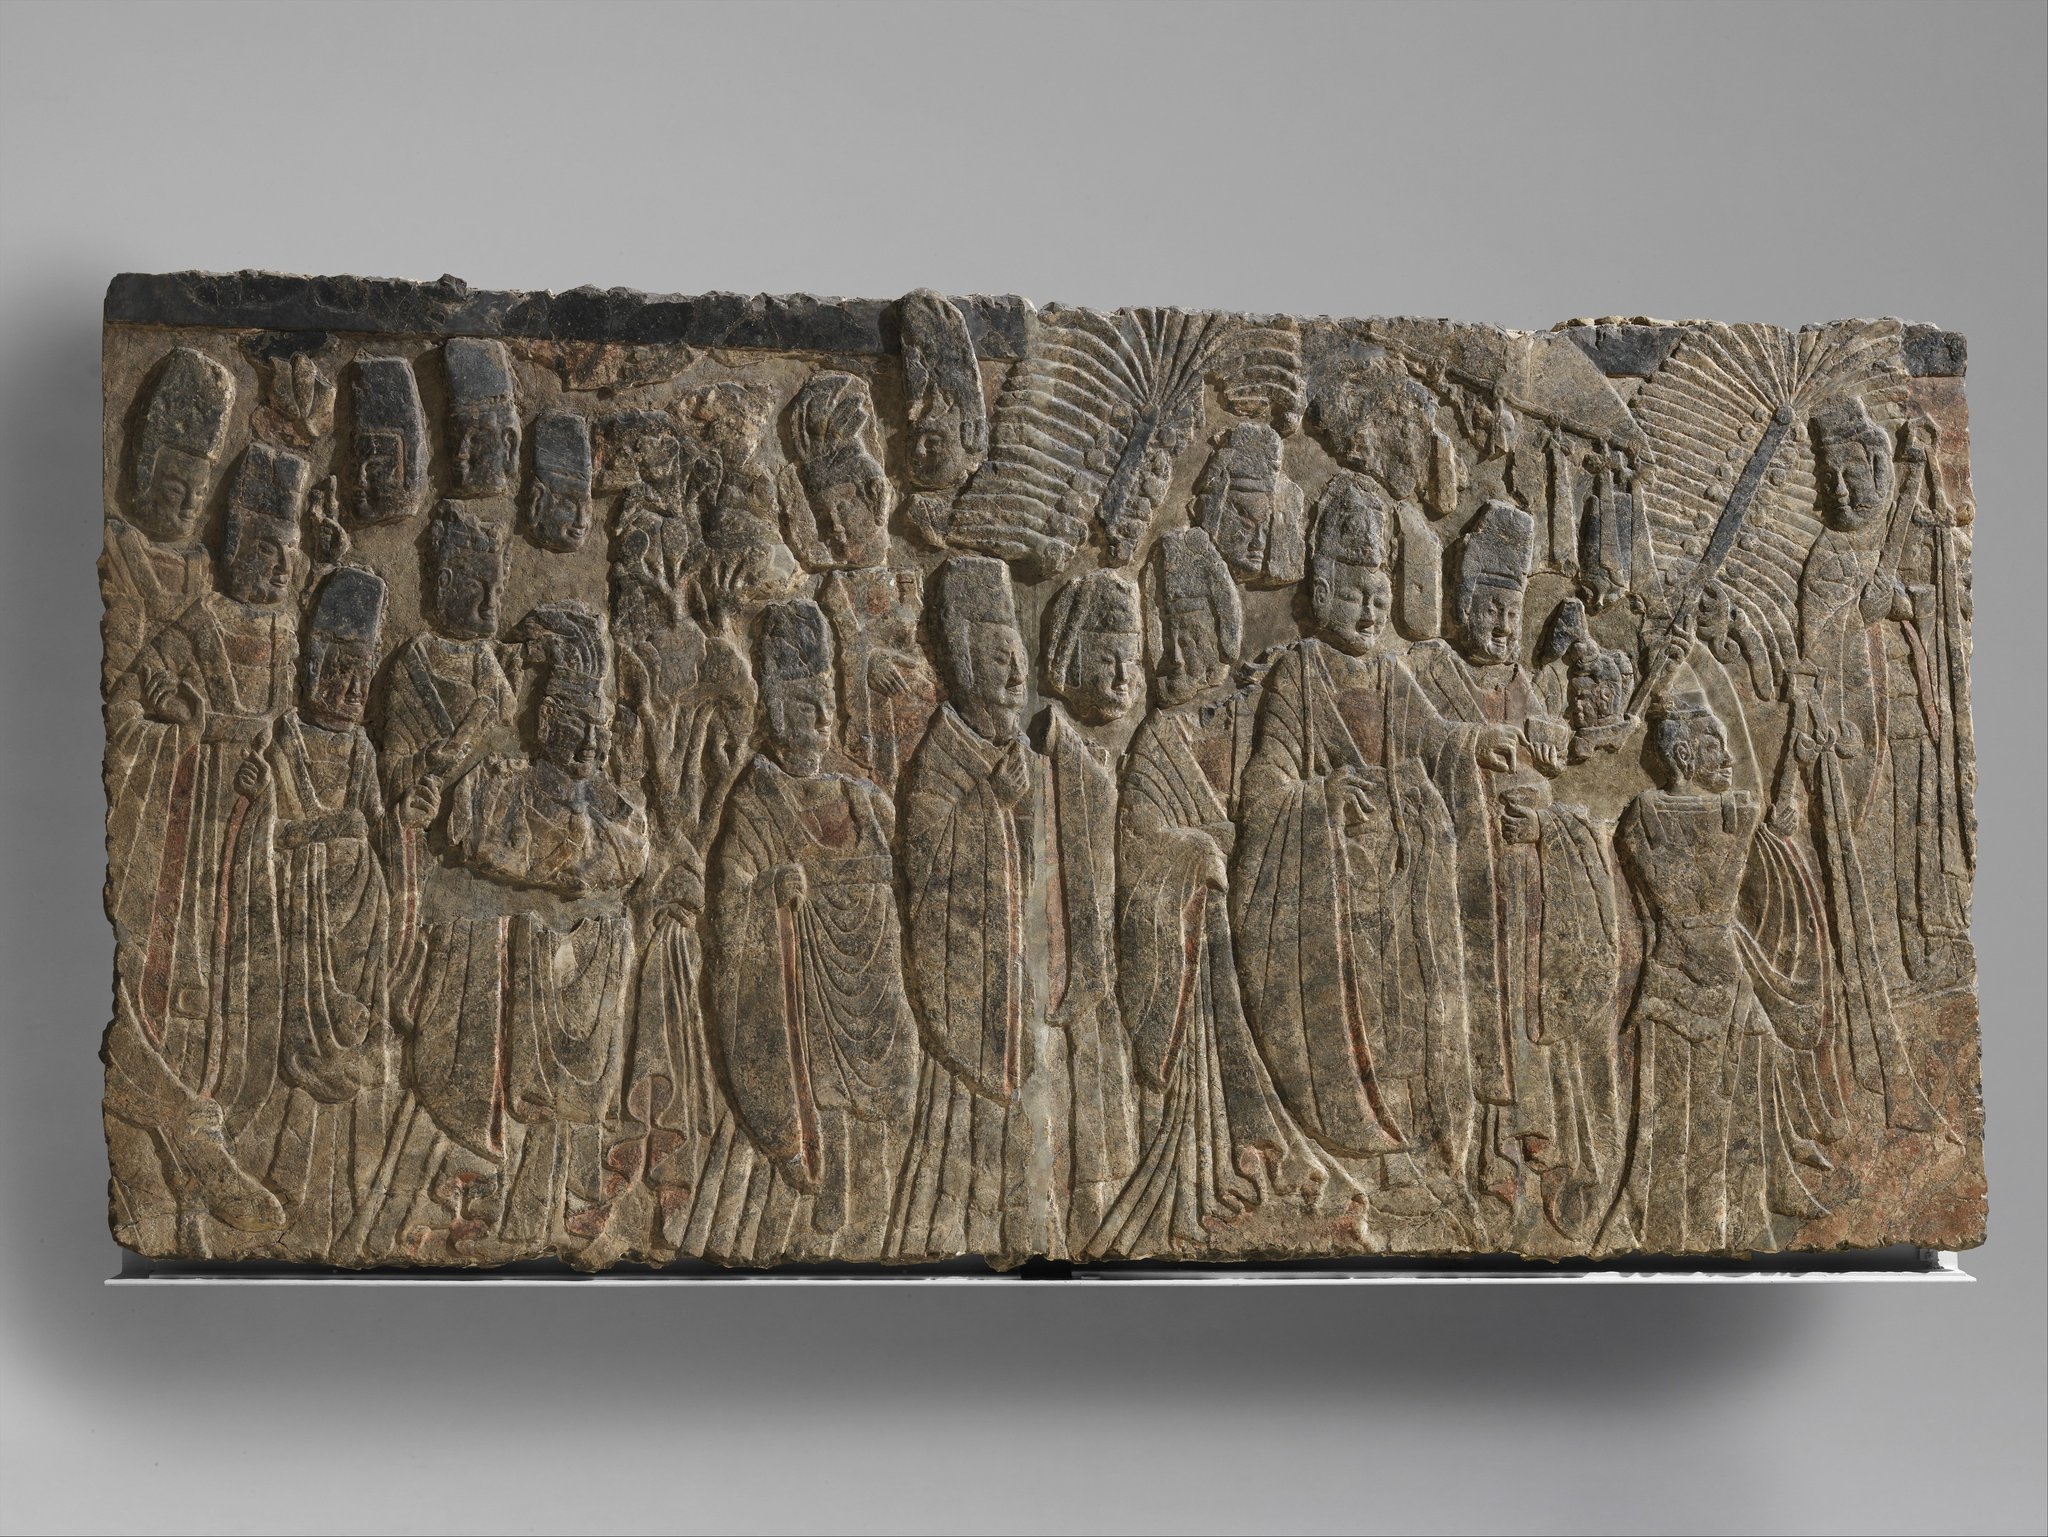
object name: relief panel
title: Emperor Xiaowen and his entourage worshipping the Buddha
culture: chinese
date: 522-523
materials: limestone, pigment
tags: men,women